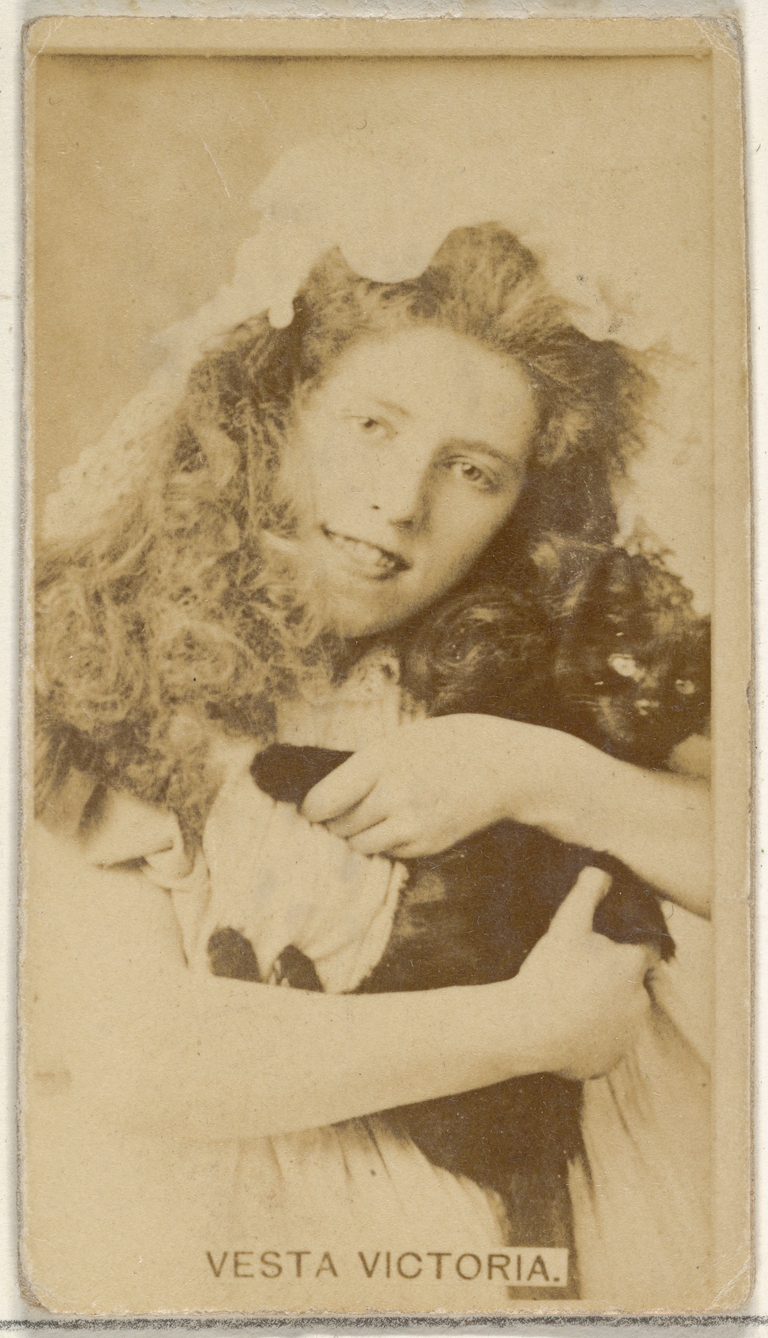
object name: photograph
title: Vesta Victoria, from the Actors and Actresses series (N45, Type 8) for Virginia Brights Cigarettes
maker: allen & ginter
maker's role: publisher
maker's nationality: american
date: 1888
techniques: albumen silver print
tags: portraits,women,cats,actresses